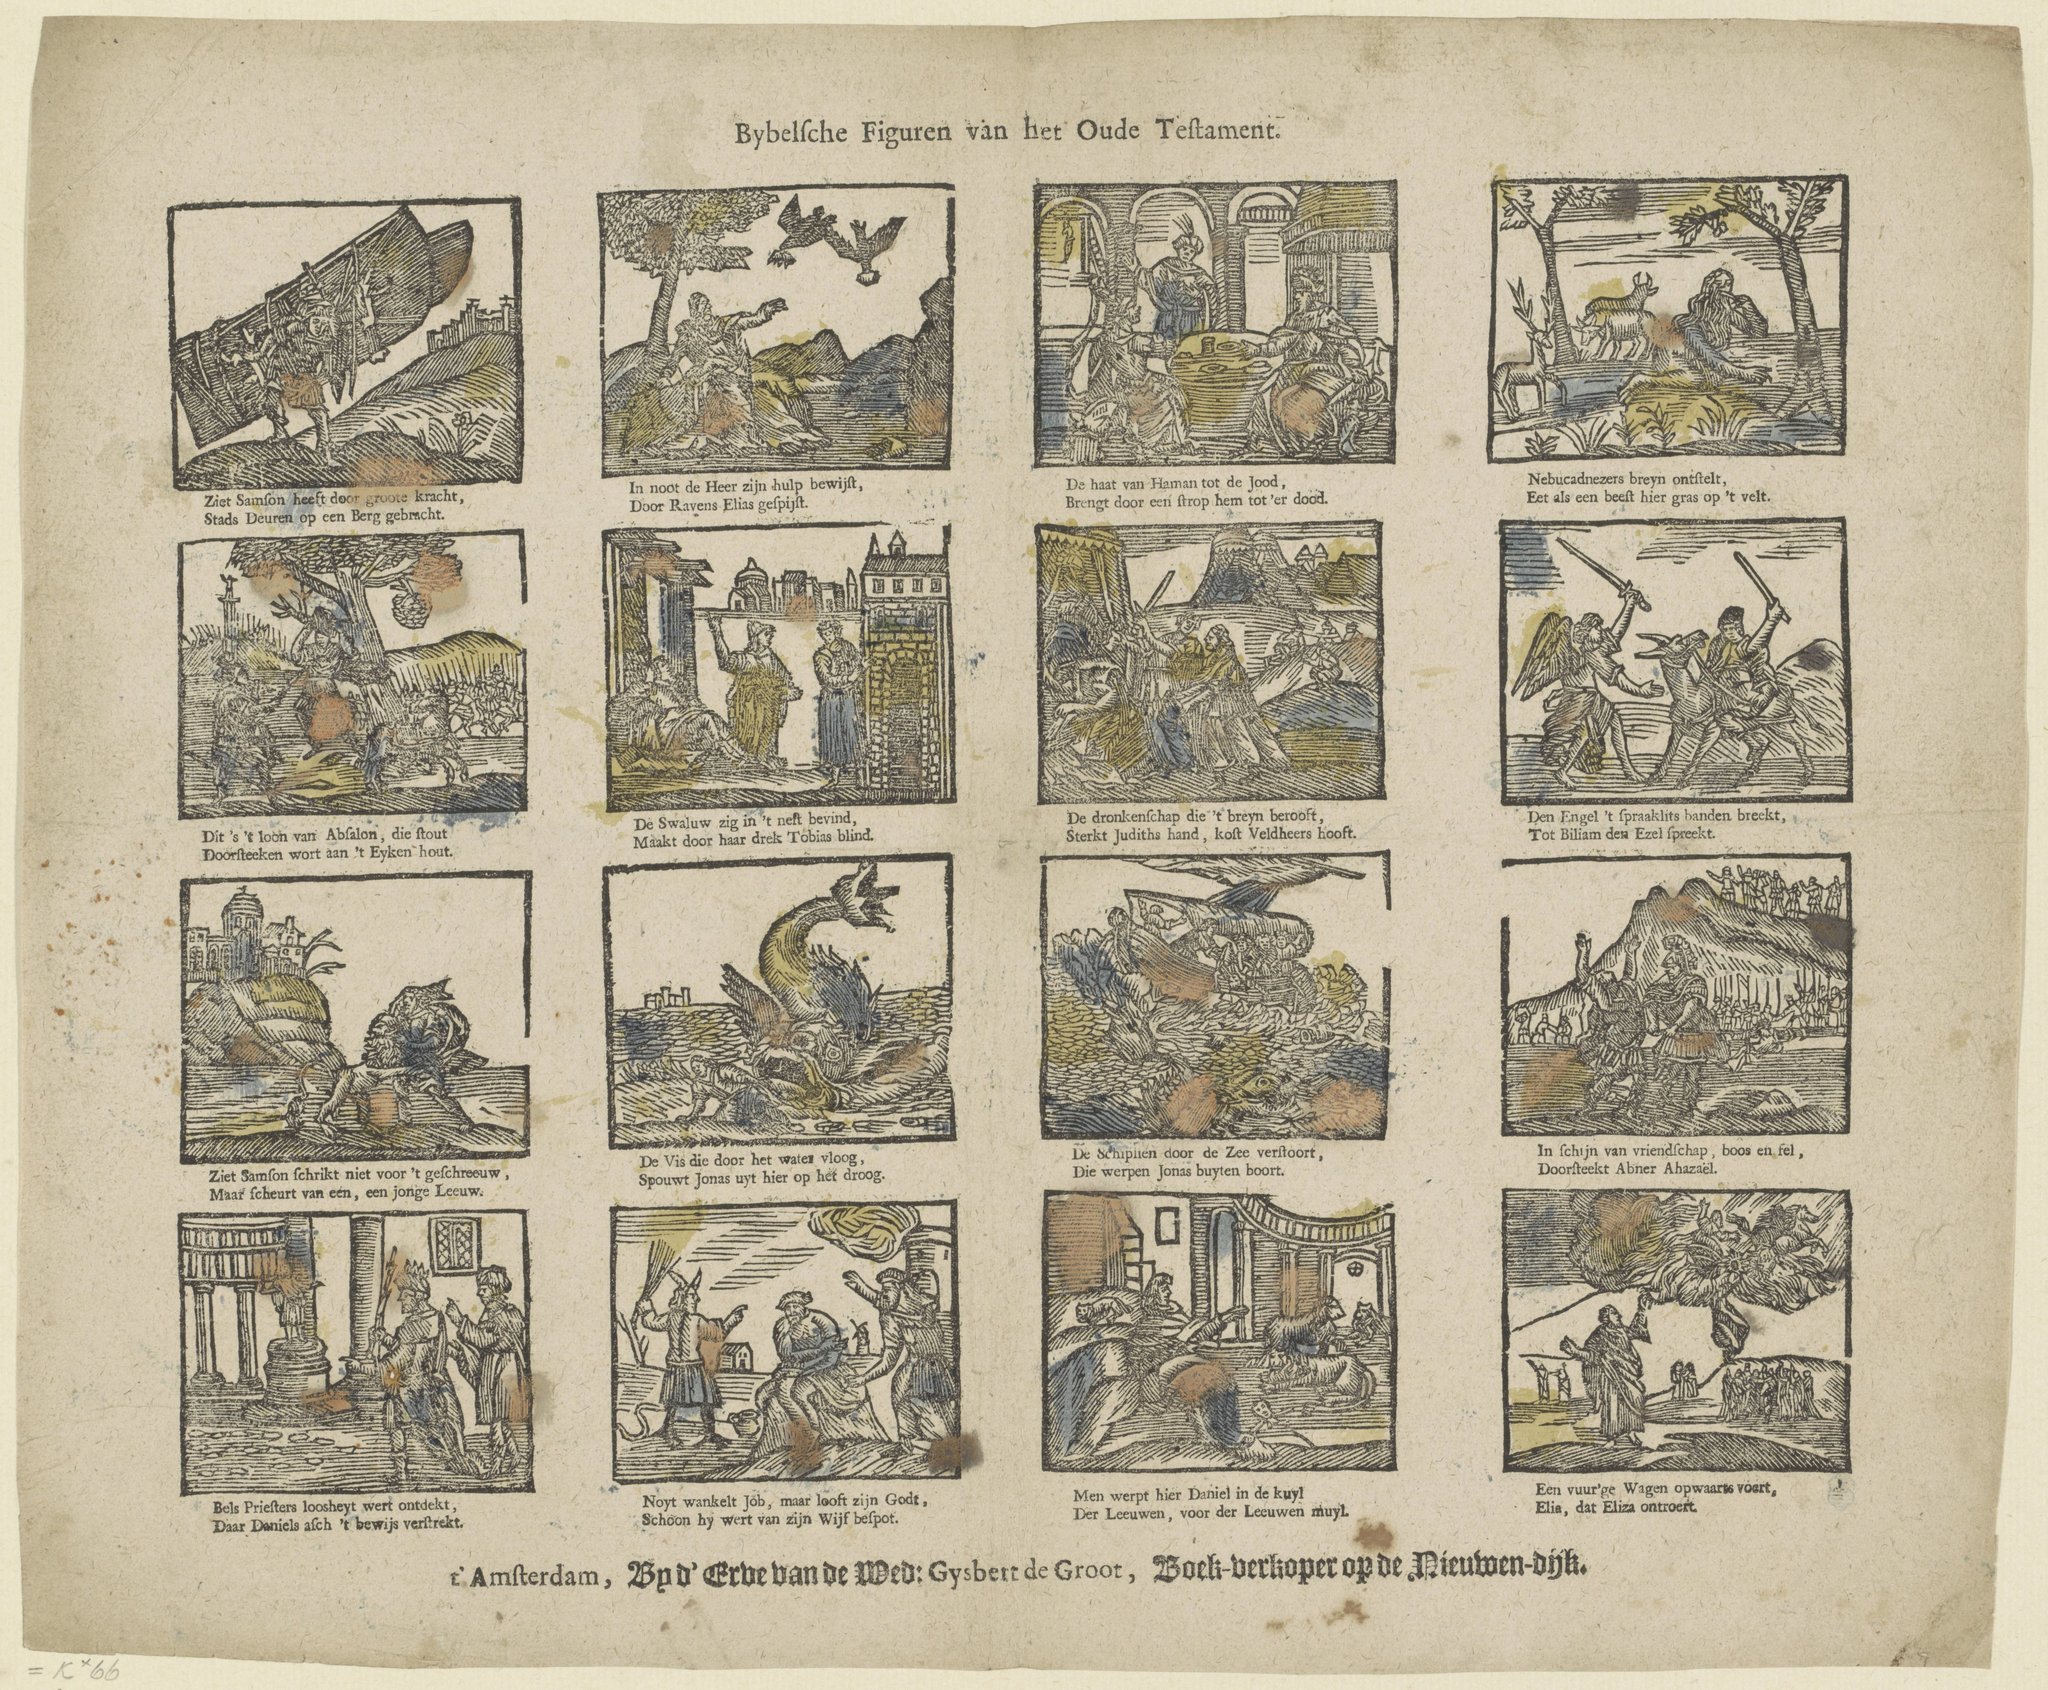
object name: popular print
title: Bijbelsche figuren van het Oude Testament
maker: Anonymous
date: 1725-1738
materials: paper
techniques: colour, letterpress printing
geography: amsterdam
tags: samson carries the doors on his shoulders to the top of a hill near hebron, a bird dropping falls in tobit's eyes, after a three-day sojourn in the belly of the monster jonah is cast on dry land; jonah may be shown nude and bald-headed, old testament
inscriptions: collector's mark: Lugt 2760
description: Blad met 16 voorstellingen van verhalen uit het Oude Testament, zoals Simson die de stadspoort van Gaza een bergtop op sleept, Tobit die blind wordt door de poep van een zwaluw en Jona die uit de vis wordt gespuugd. Onder elke afbeelding een tweeregelig vers.